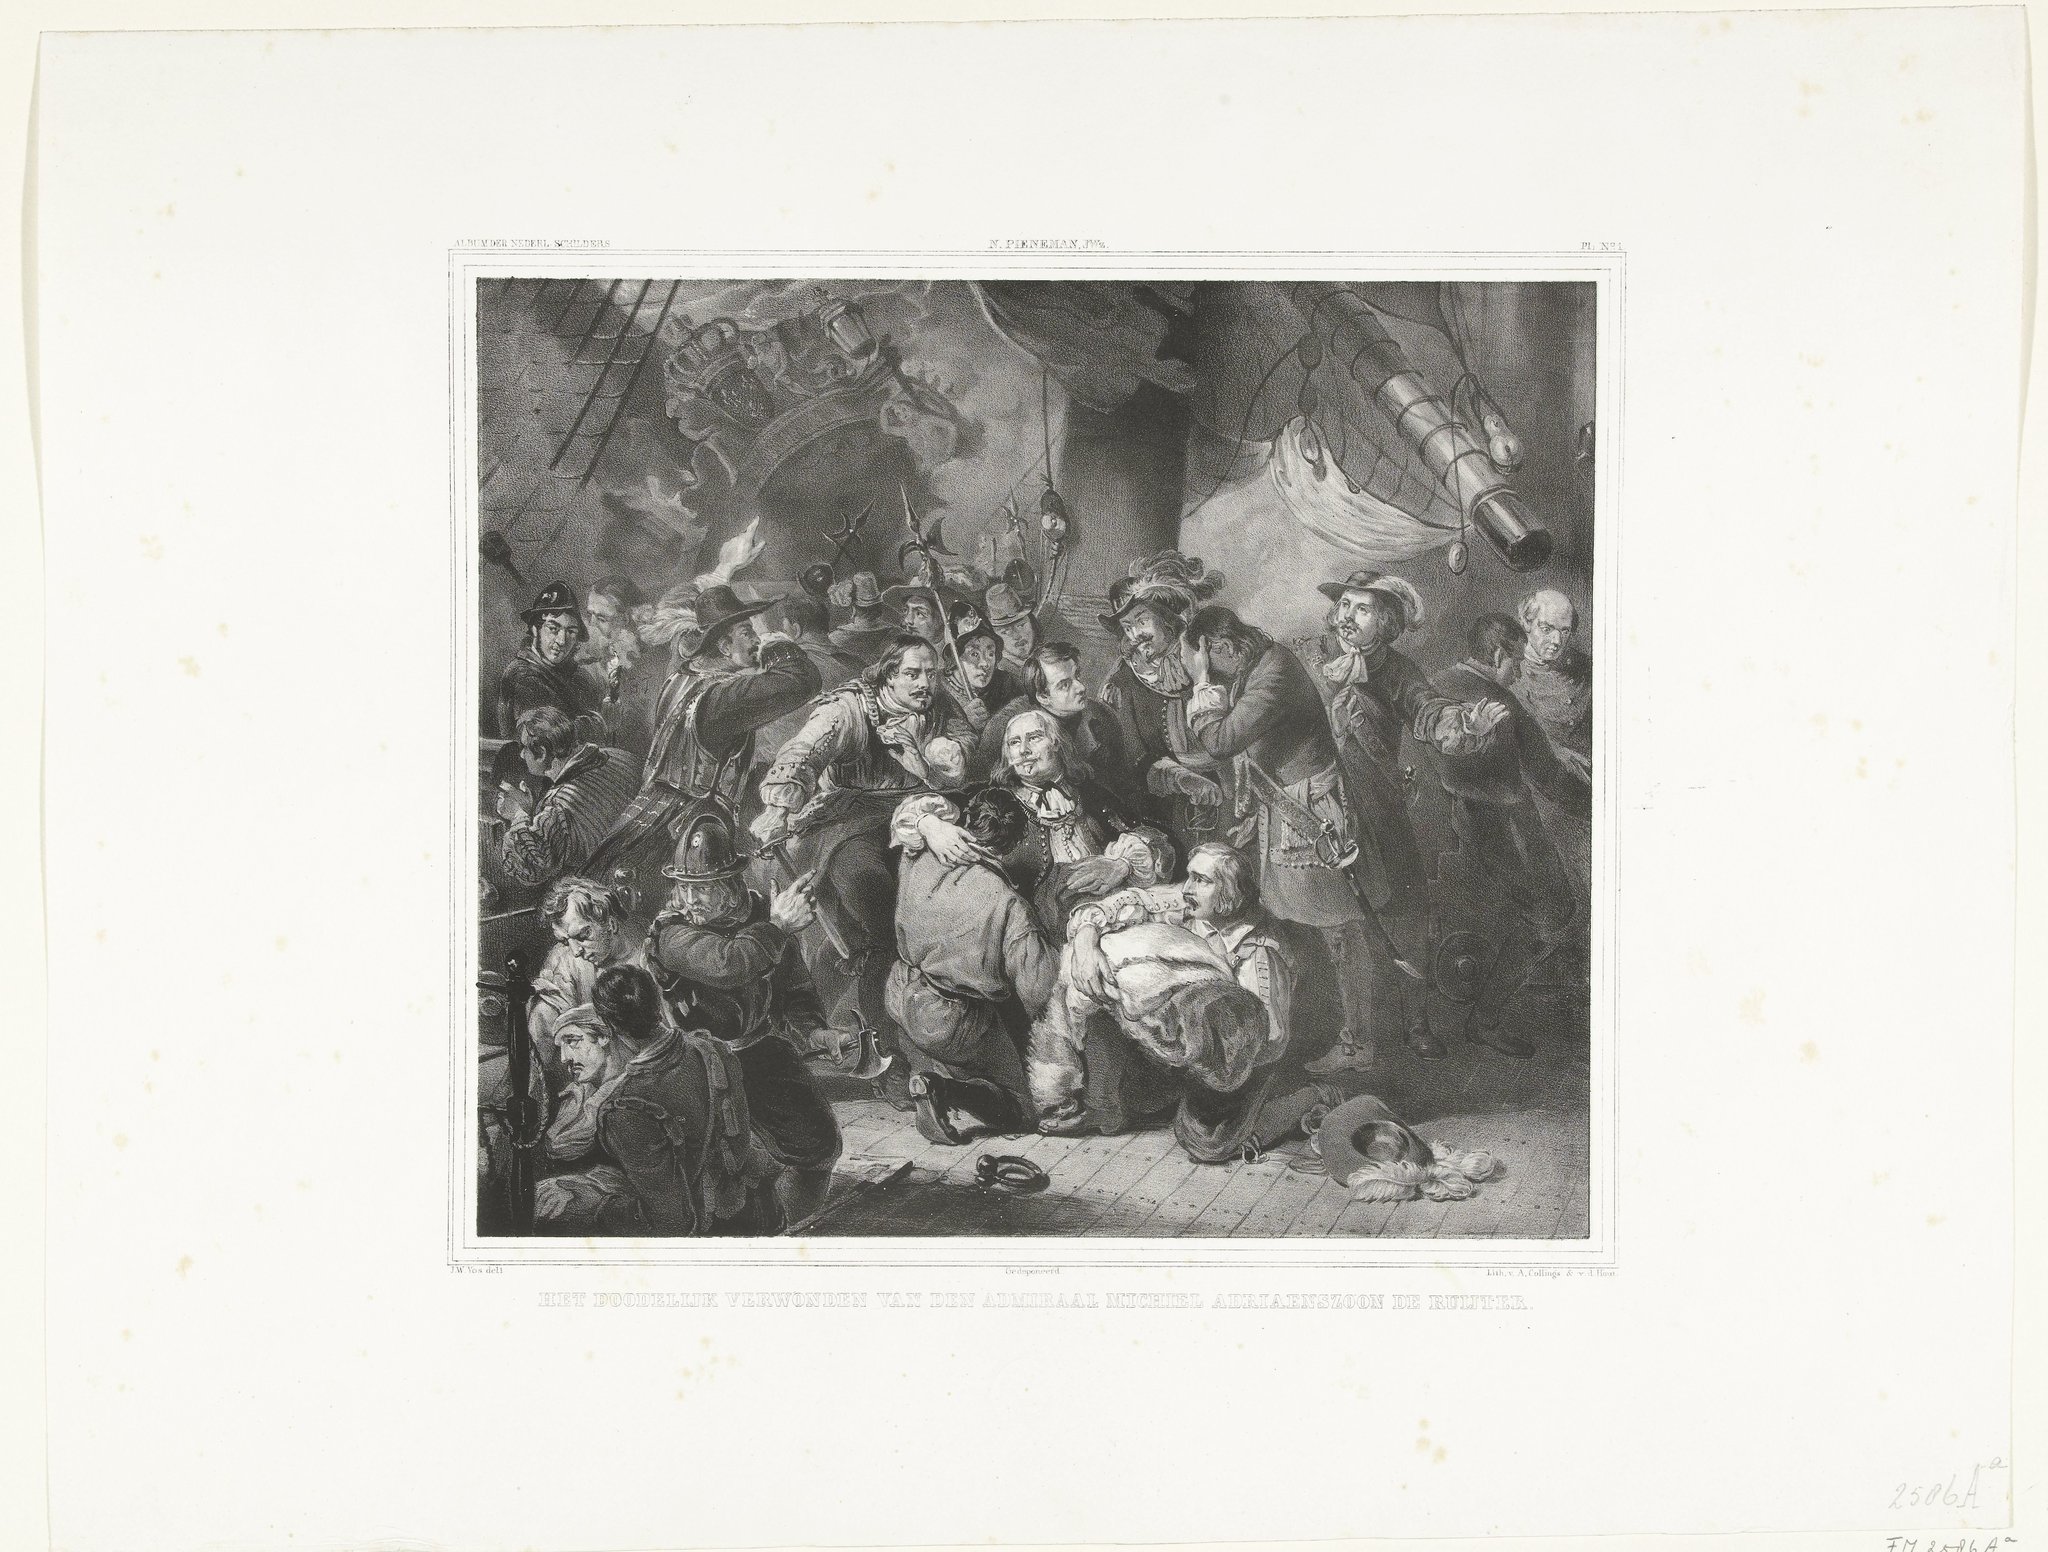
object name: history print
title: Admiraal Michiel Adriaenszoon de Ruyter raakt tijdens de zeeslag bij Agosta dodelijk gewond, 1676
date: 1832-1840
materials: paper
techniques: lithograph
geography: rotterdam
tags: flushing, michiel adriaenszoon de ruyter, medical aid and nursing of the sick and wounded, battle (+ naval force), battle of augusta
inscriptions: collector's mark: Lugt 2165, check stamp: ‘A. Collings v d Hout Rotterdam’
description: Admiraal Michiel Adriaenszoon de Ruyter raakt dodelijk gewond tijdens de zeeslag bij Agosta op 22 april 1676 tussen een gecombineerd Hollands-Spaanse vloot onder De Ruyter en een Franse vloot onder Abraham Duquesne. In alle hevigheid van de slag wordt De Ruyter wordt door zijn bemanning in een laken gewikkeld en naar zijn kajuit gedragen. Pl. no. 1 uit het "Album der Nederl. Schilders".